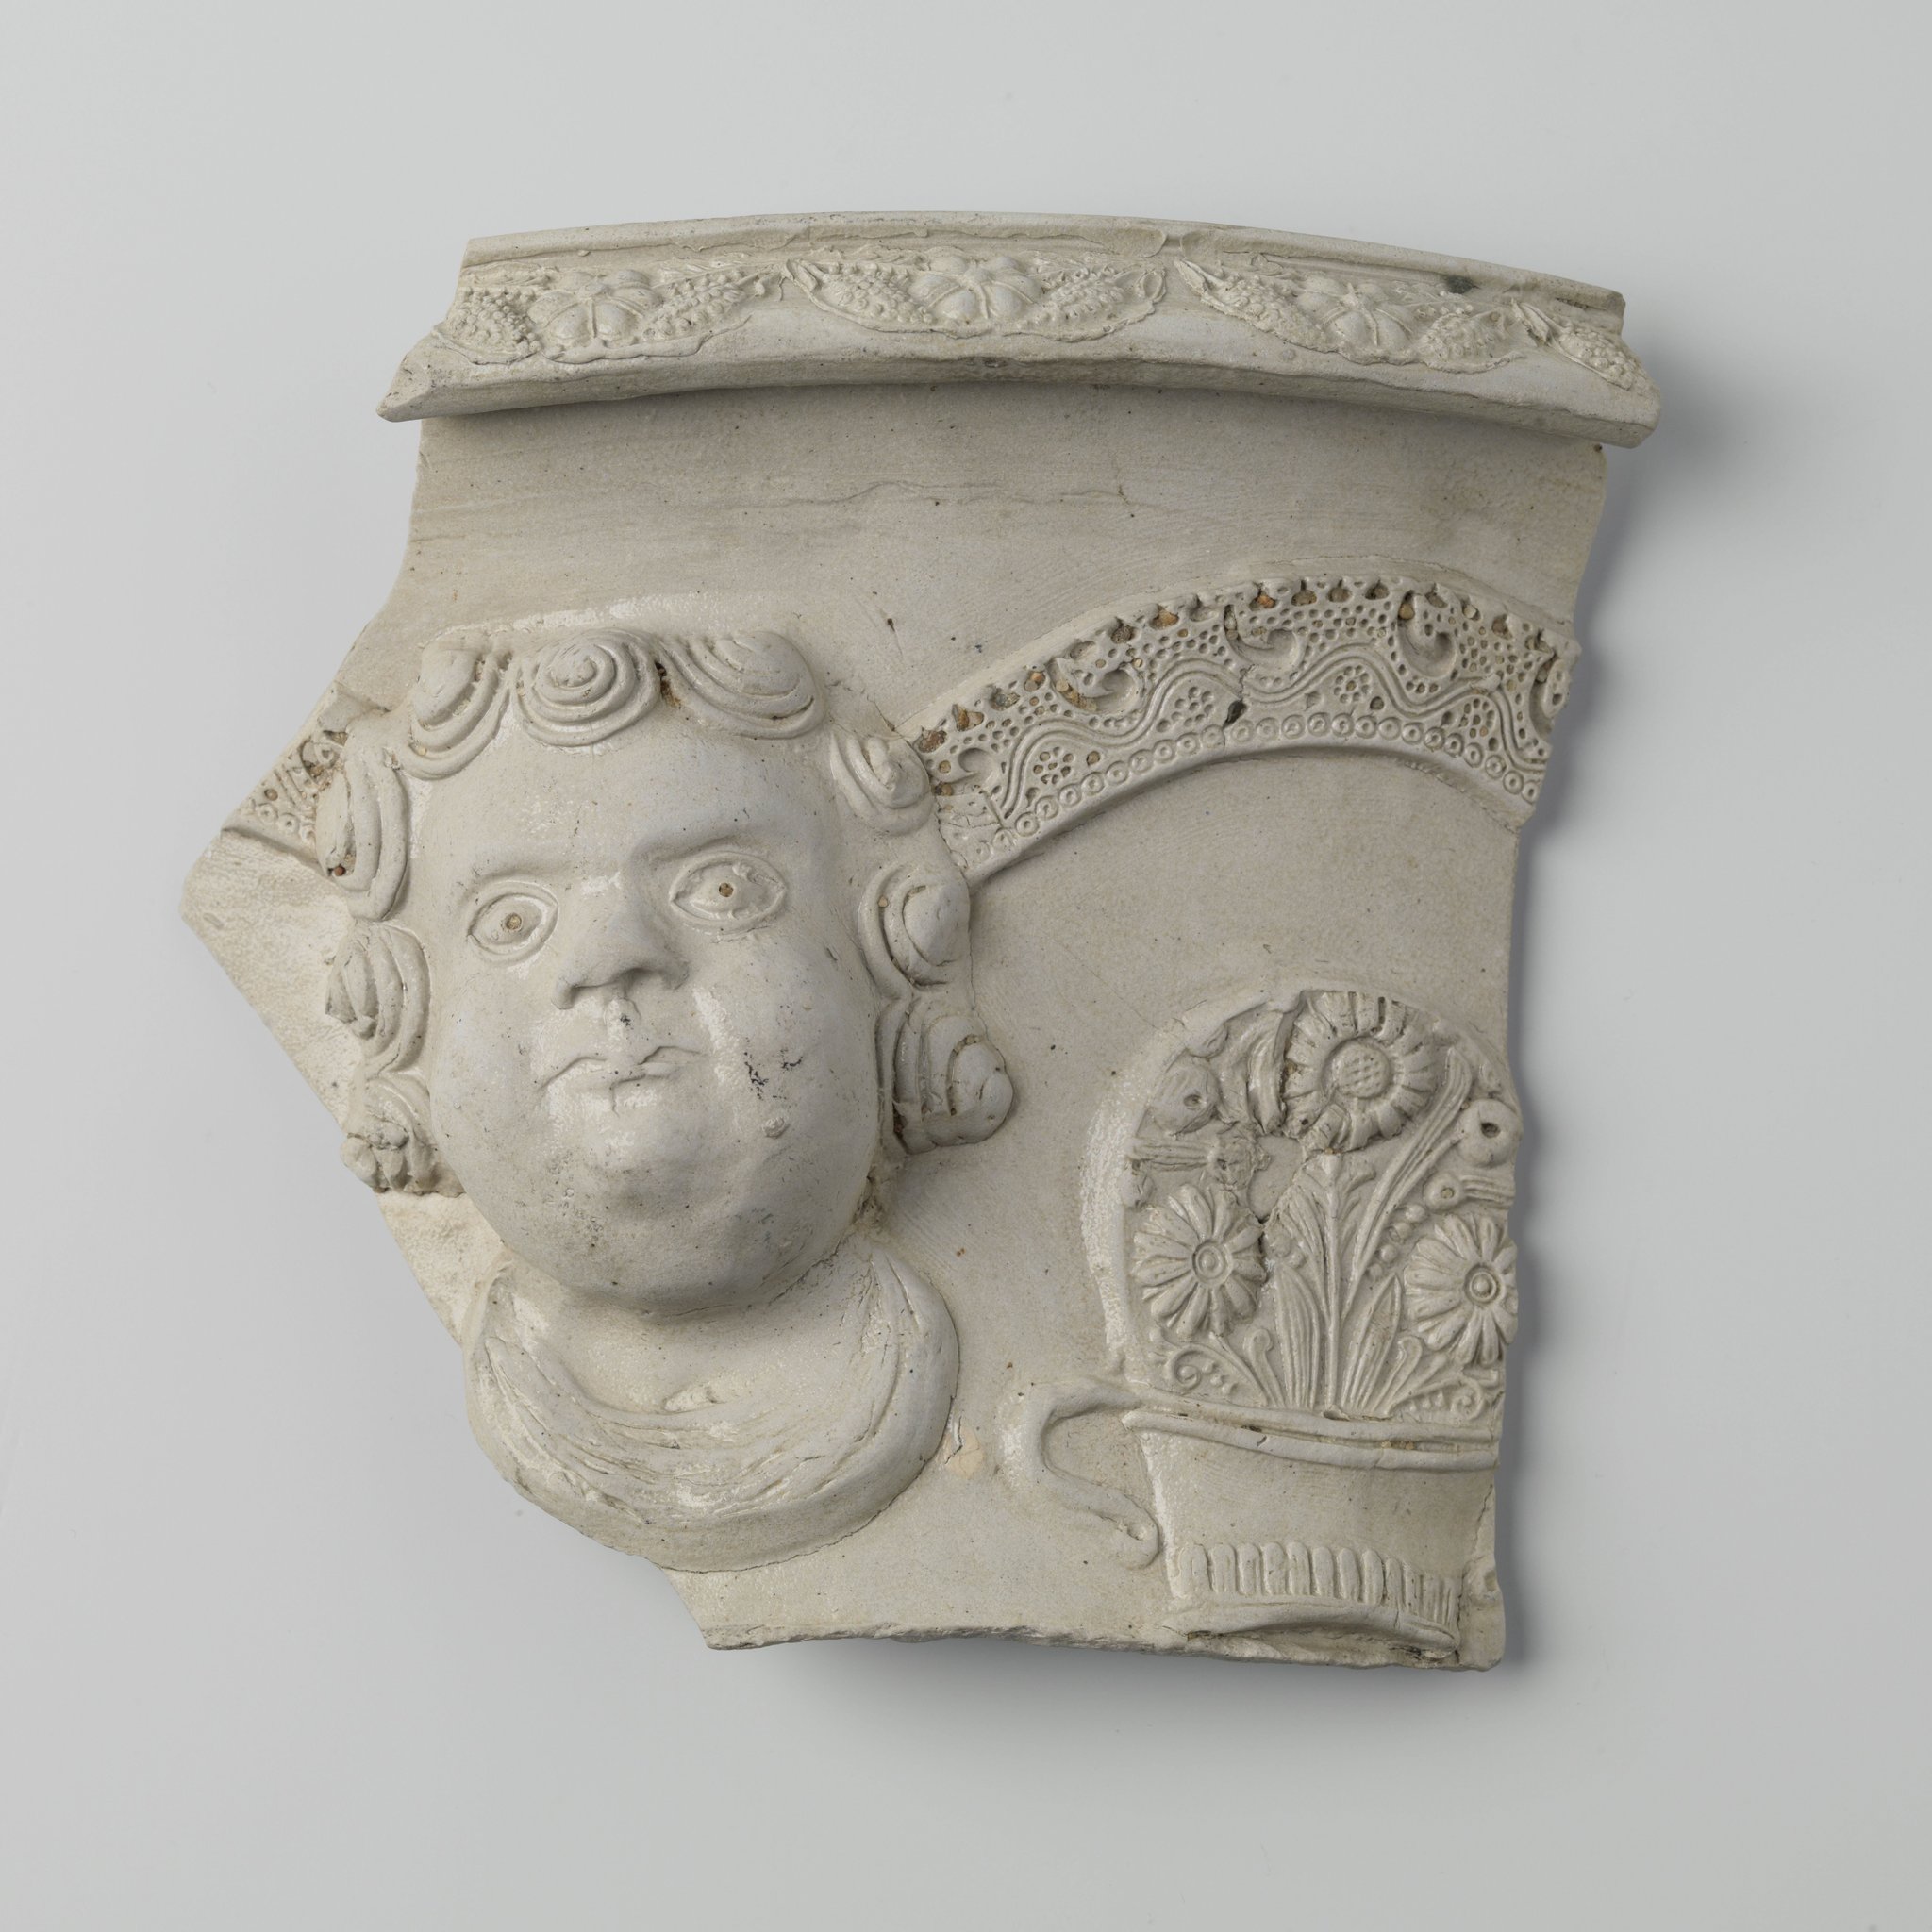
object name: fragment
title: Fragment of a flower pot with the head of a child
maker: Anonymous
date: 1700-1740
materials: glaze, stoneware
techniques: firing, forming, relief, turning, vitrification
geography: westerwald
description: Fragment van een bloempot van steengoed. Versierd met een gedrukte en opgelegde decoratie in reliëf van een kinderhoofd of engelenkop, omgeven door decoratieve banden en een bloemenmand. Op de rand een band met druivenranken. Westerwald.